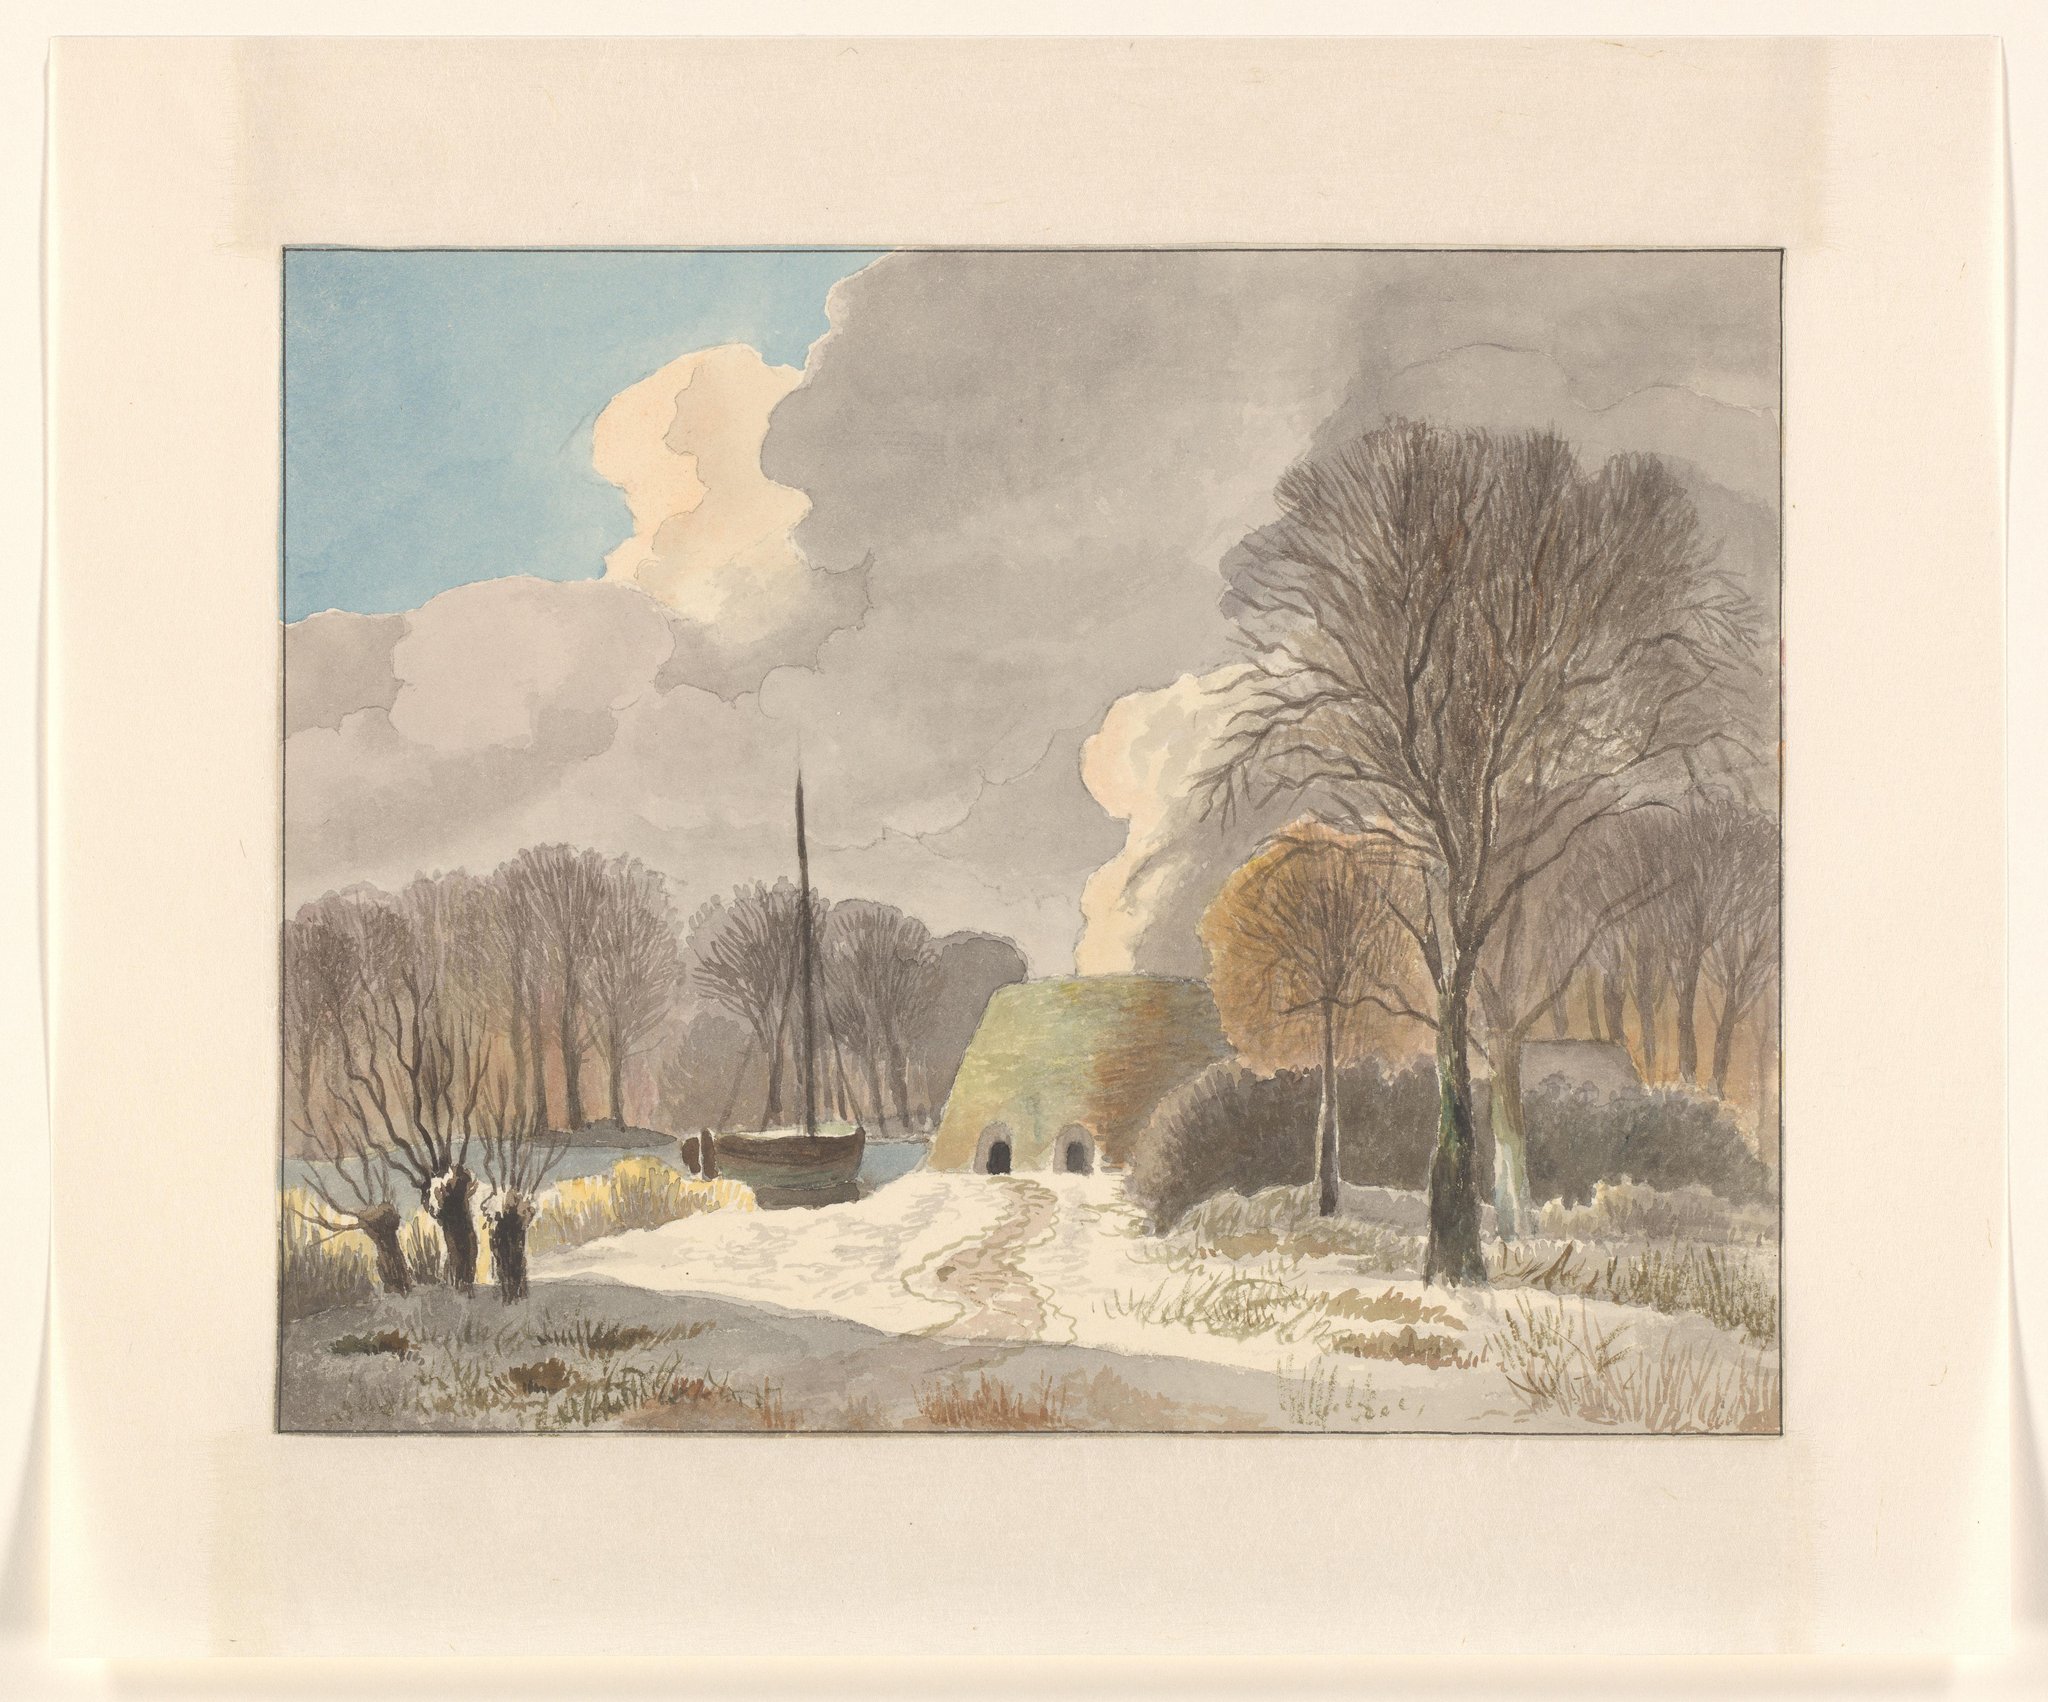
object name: drawing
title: Winterlandschap met brandende kalkoven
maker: johannes van reijn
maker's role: draughtsman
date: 1800-1900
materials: paper, pencil, watercolor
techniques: brush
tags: industries ~ clay, sand, chalk, etc., landscapes, winter, 'hyems'; 'inverno' (ripa)